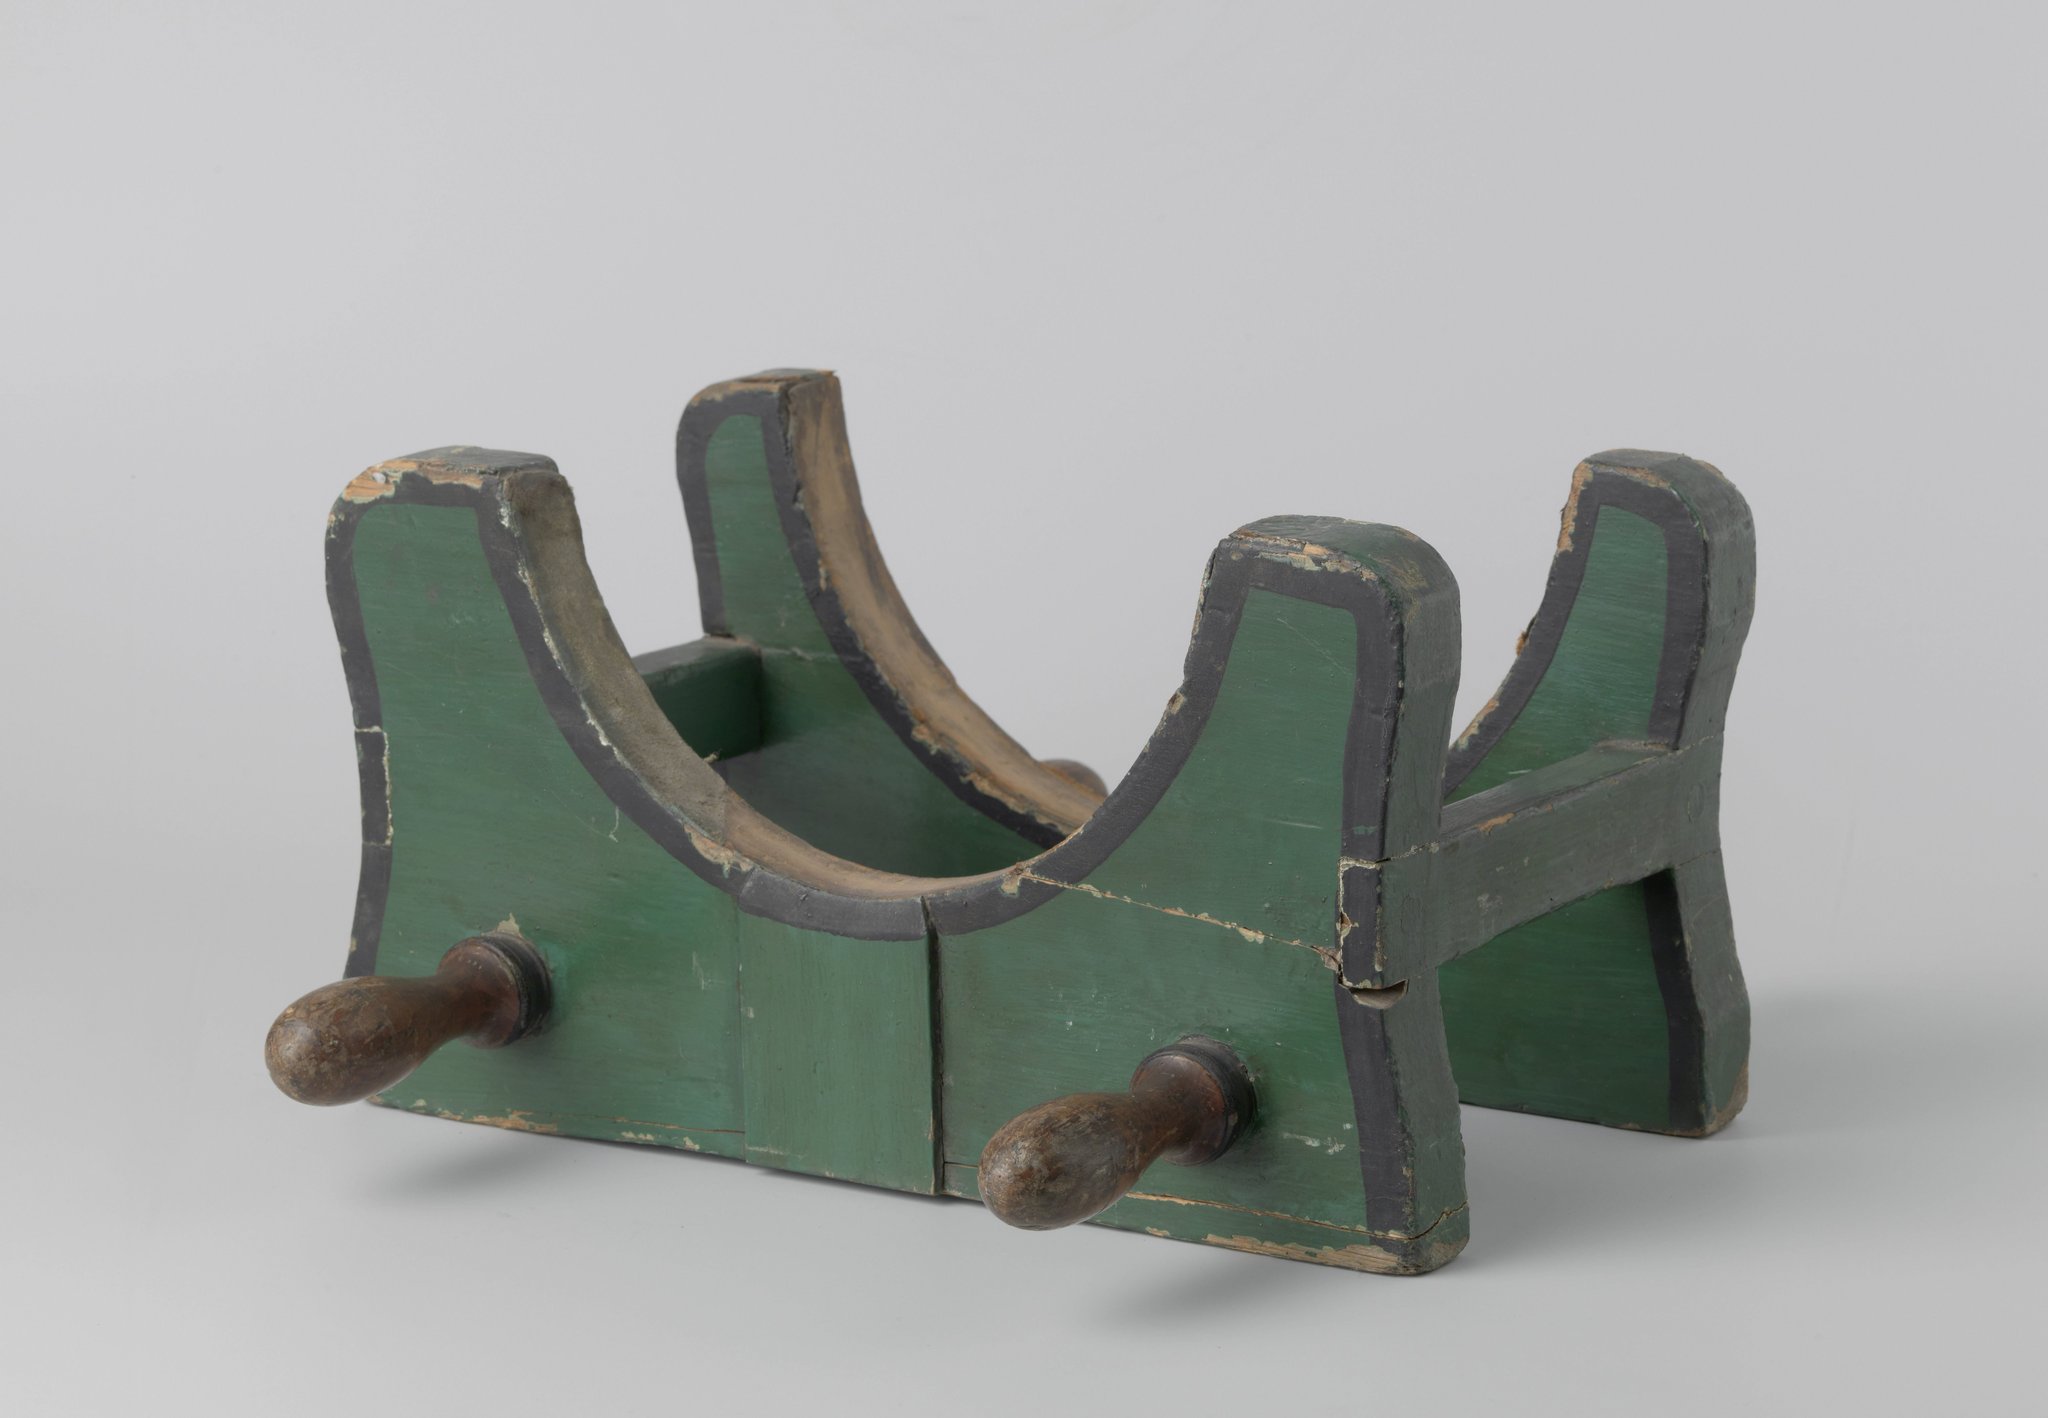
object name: drager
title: Granaatdrager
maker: Anonymous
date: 1850-1900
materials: leather, wood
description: Twee houten steunen, ingelegd met leer, en aan de ronde binnenzijde voorzien van een dun laag leer. De drager heeft een H-vorm en heeft aan beide buitenzijde twee houten handgrepen.